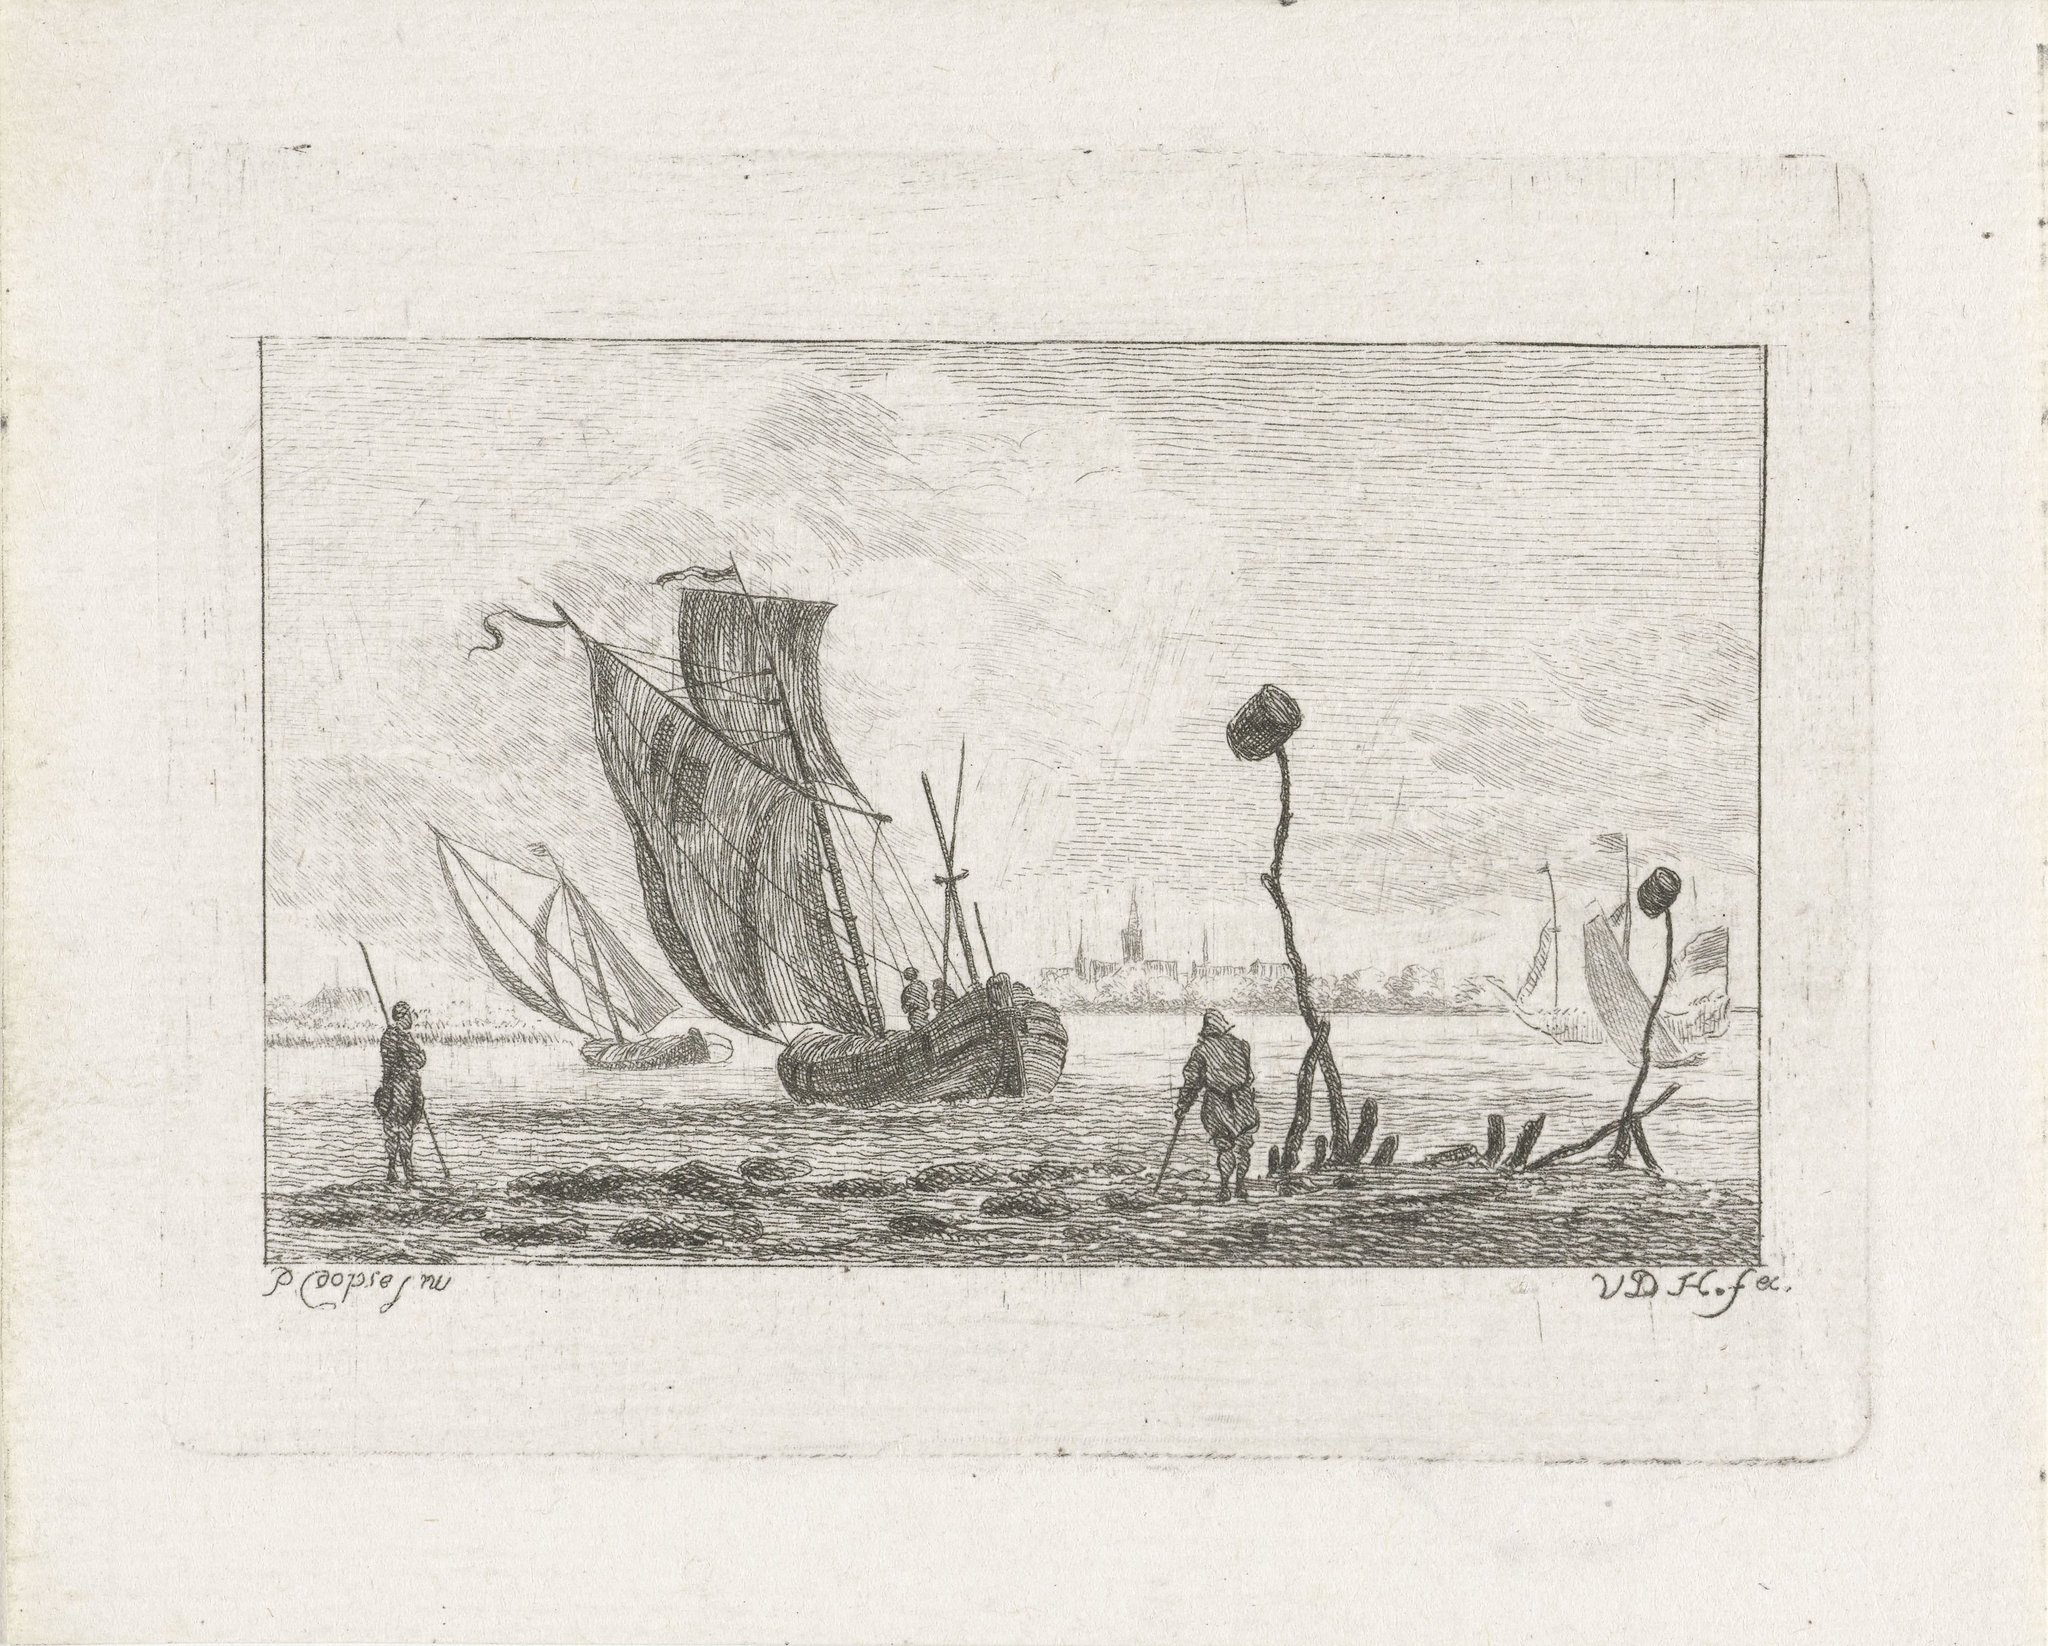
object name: print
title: Zeilschepen op een rivier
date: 1745-1785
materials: paper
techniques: etching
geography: northern netherlands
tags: sailing-ship, sailing-boat, landscapes with waters, waterscapes, seascapes (in the temperate zone) (+ landscape with figures, staffage)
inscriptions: collector's mark: Lugt 240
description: Een riviergezicht met zeilende schepen, op de voorgrond twee figuren en twee bakens.